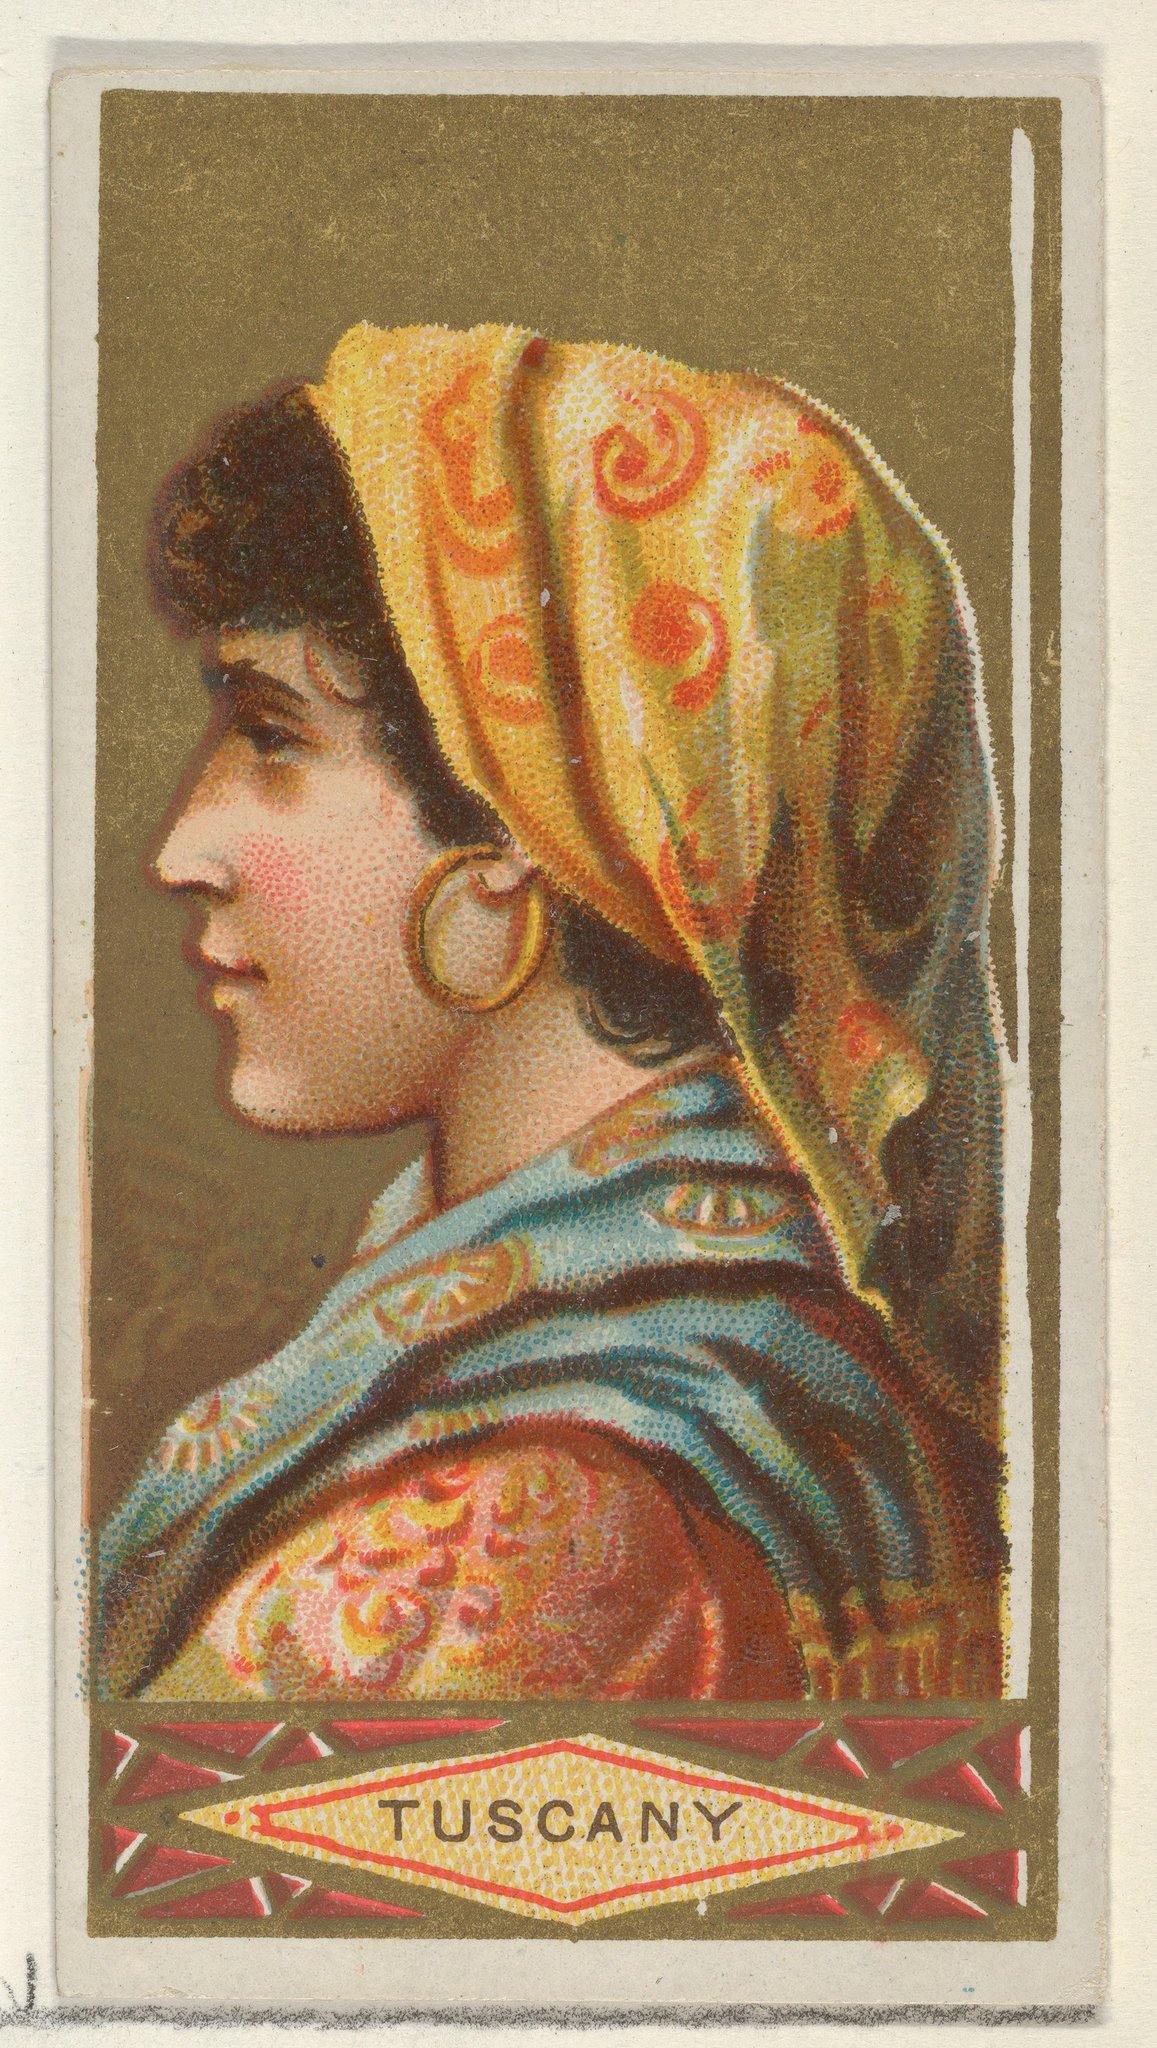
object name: print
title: Tuscany, from the Types of All Nations series (N24) for Allen & Ginter Cigarettes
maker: allen & ginter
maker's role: publisher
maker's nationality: american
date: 1889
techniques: color lithograph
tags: profiles,women